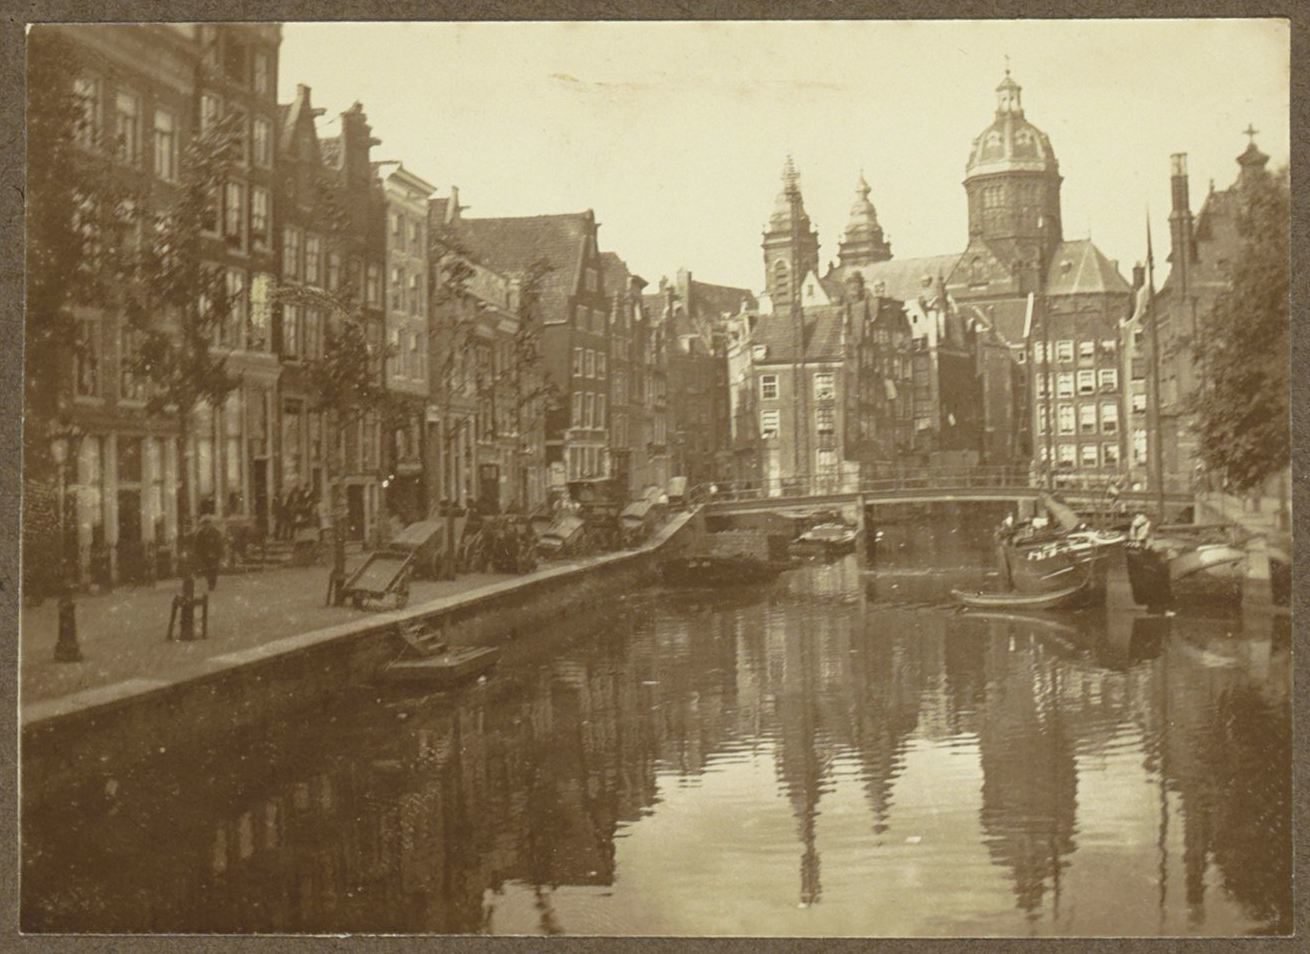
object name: photograph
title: Nicolaaskerk in Amsterdam gezien vanaf de Oudezijds Voorburgwal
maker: Anonymous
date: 1910-1930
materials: paper, photographic support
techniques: gelatin silver print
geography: oudezijds voorburgwal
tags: canal, church (exterior)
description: Onderdeel van Album met foto's van Amsterdam en omgeving.